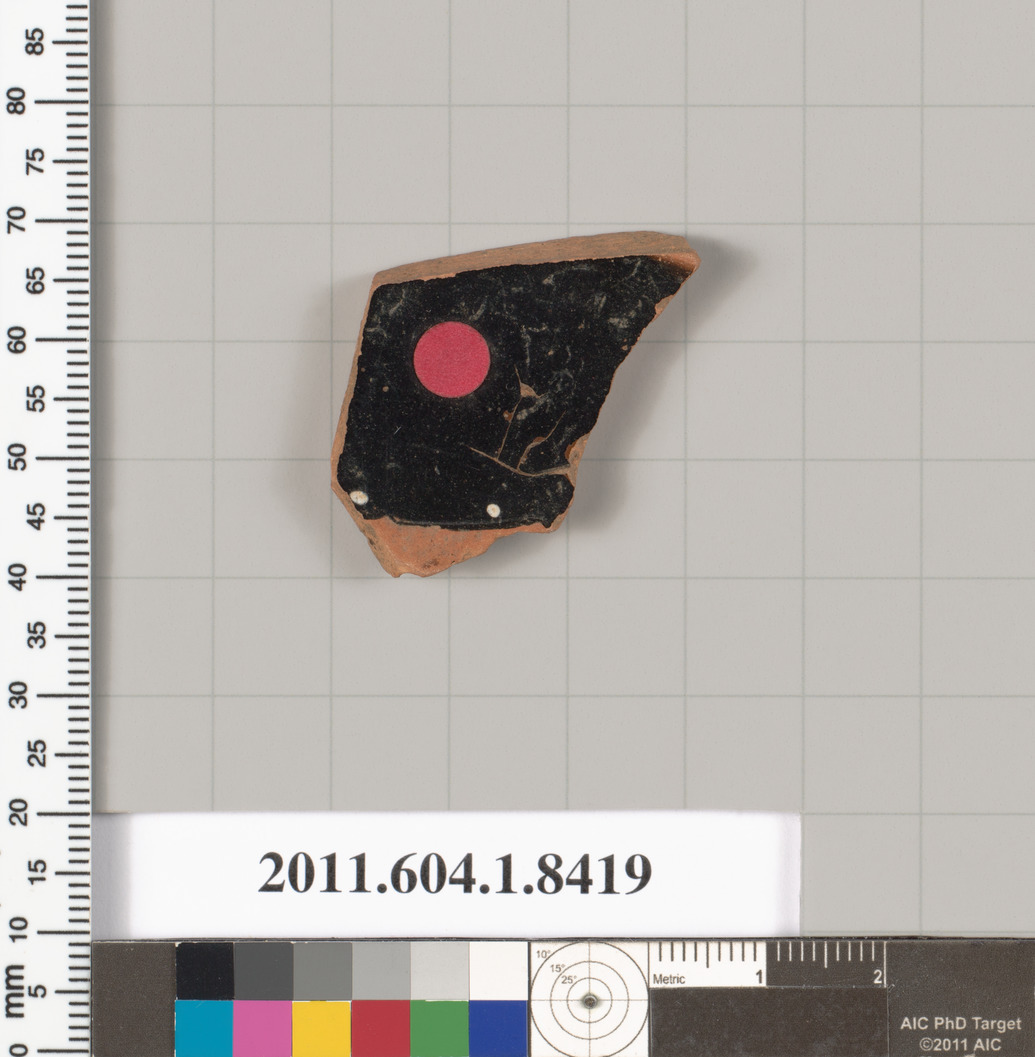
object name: kylix fragment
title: Terracotta fragment of a kylix (drinking cup)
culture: greek, attic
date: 375-351 BCE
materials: terracotta